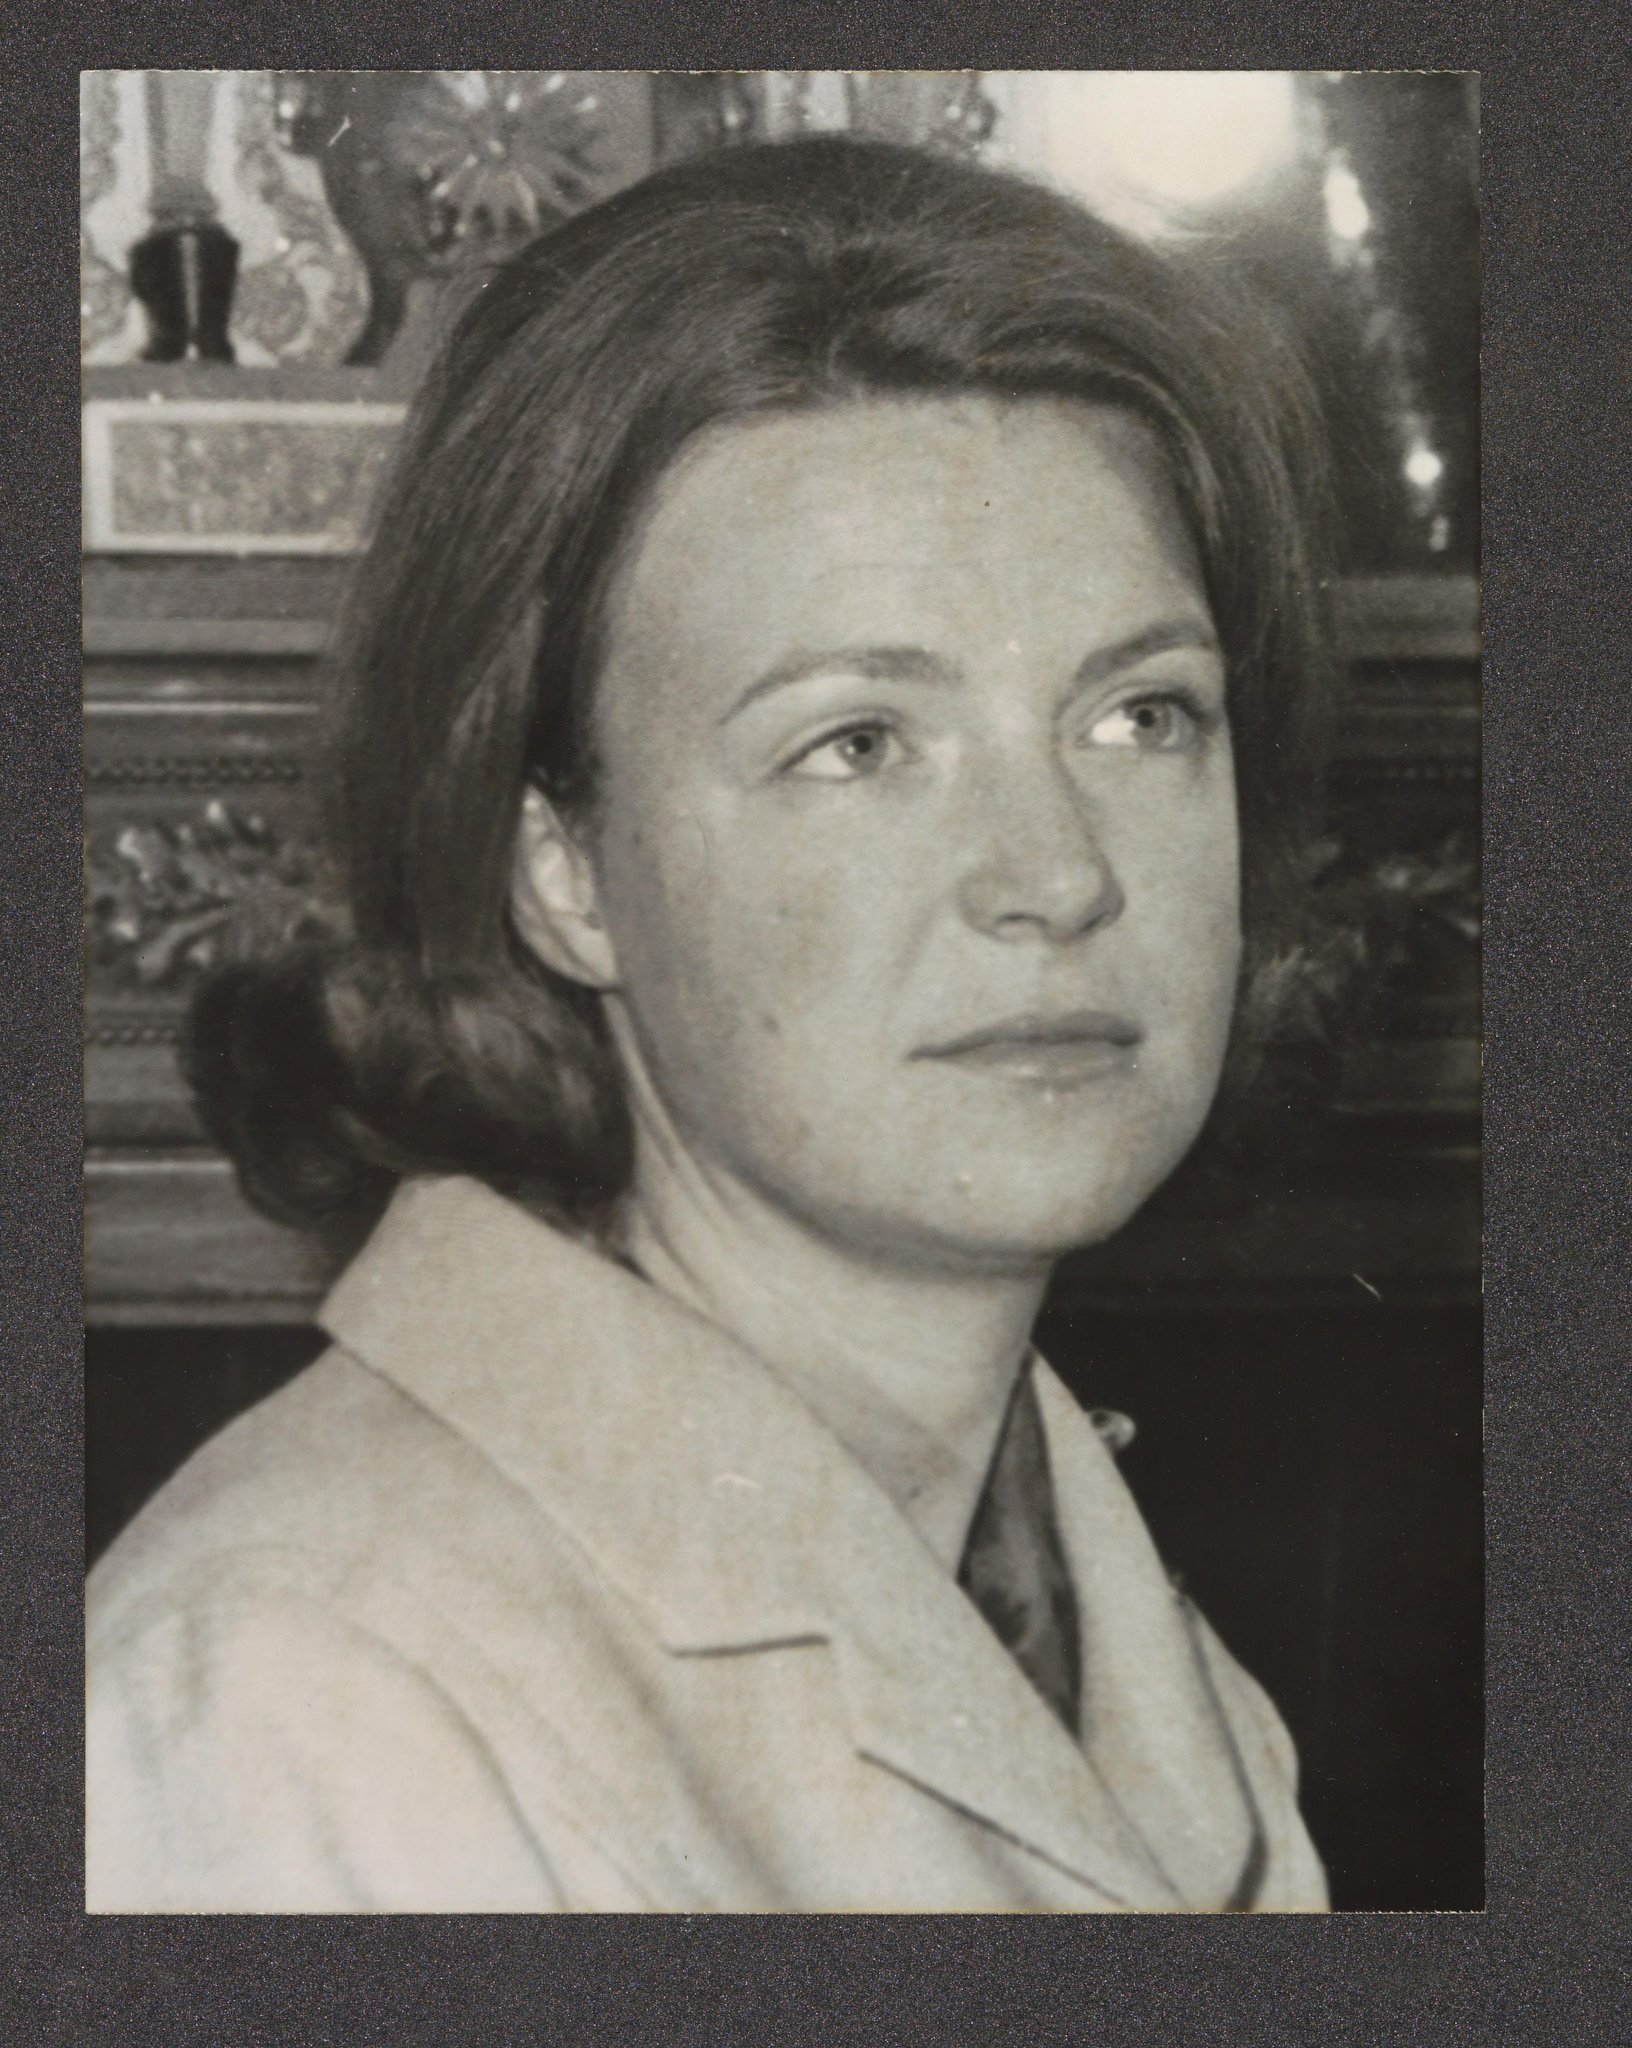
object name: photograph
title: La Princesse Irene est tres fatiguee et les nerf a bout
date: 1960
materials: paper, photographic support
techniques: gelatin silver print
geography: netherlands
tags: paris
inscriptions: inscription: ‘la Princesse Irene de Hollande ... la lecture de sa declaration a la Presse’, signature: ‘COPYRIGHT / "ANEFO" / KERKSTRAAT 310 / AMSTERDAM-C. / TEL. 30744 33902 / No. [in potlood ingevuld: PRF131]’